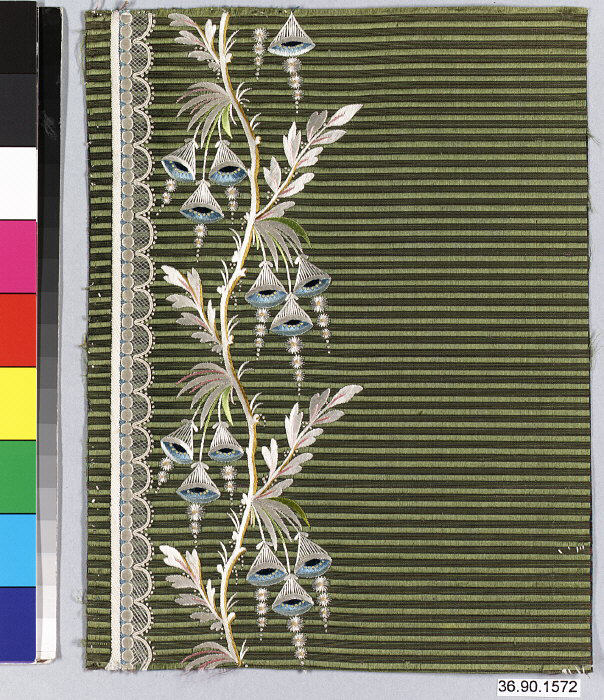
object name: sample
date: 1801-1833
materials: silk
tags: flowers